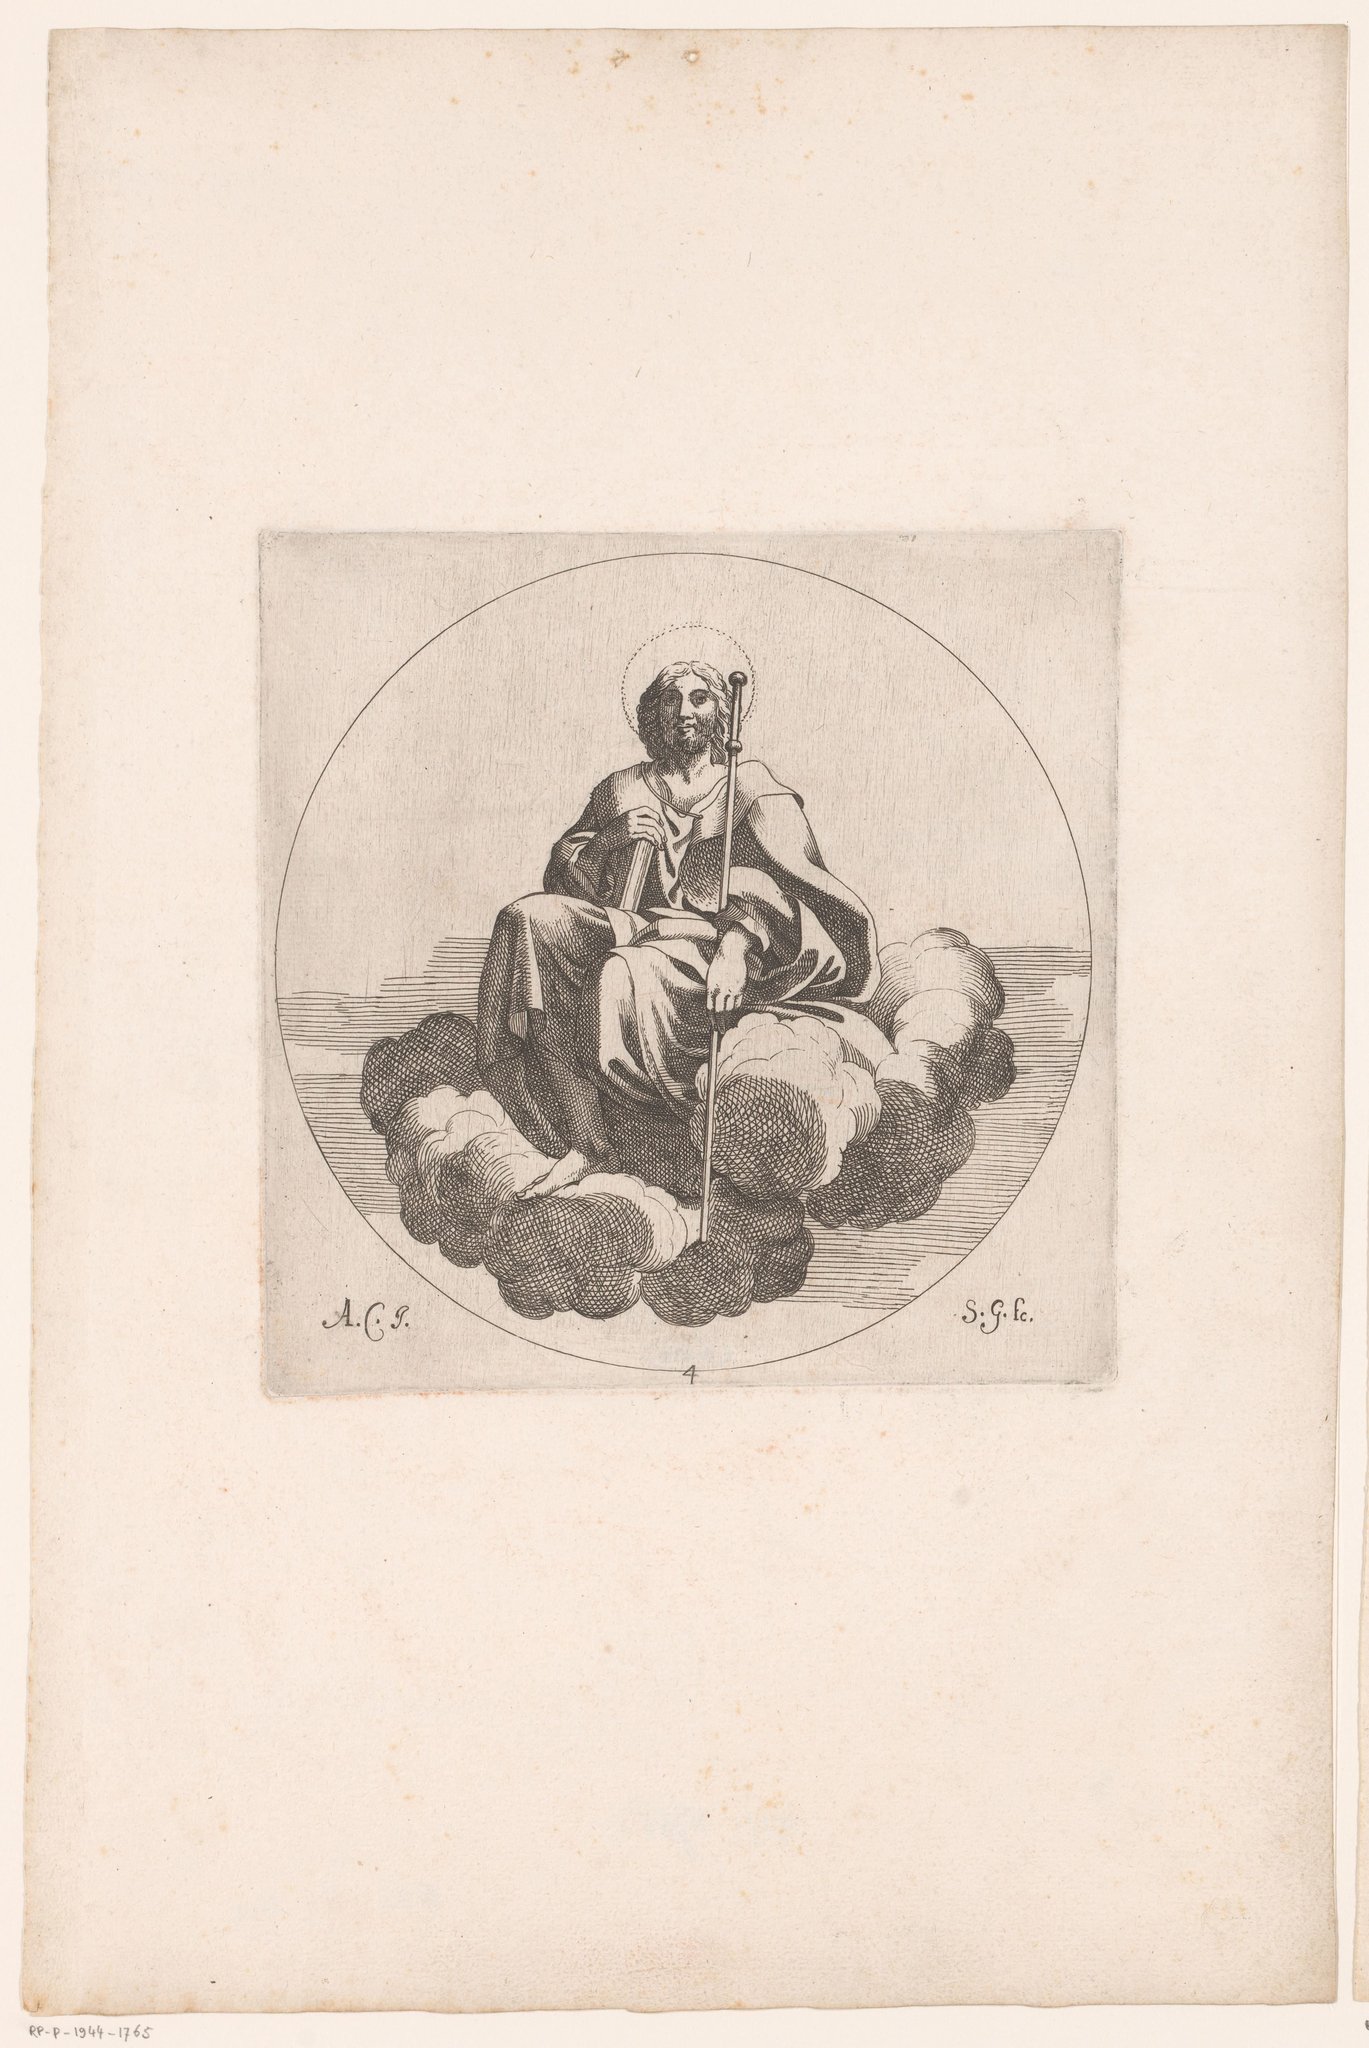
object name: print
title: Heilige Jakobus de Meerdere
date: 1646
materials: paper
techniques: etching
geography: rome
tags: life and acts of james the great (the elder)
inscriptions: collector's mark: Lugt 2228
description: Maakt deel uit van een twintigdelige serie getiteld 'Vita di San Diego dipinta nella Capella di S. Giacomo de Spagnoli a Roma' met scènes uit het leven van Juan Diego Cuauhtlatoatzin door Annibale Carracci in Herrera kapel van de Nostra Signora del Sacro Cuore te Rome. De serie werd in 1646 uitgegeven in Rome.